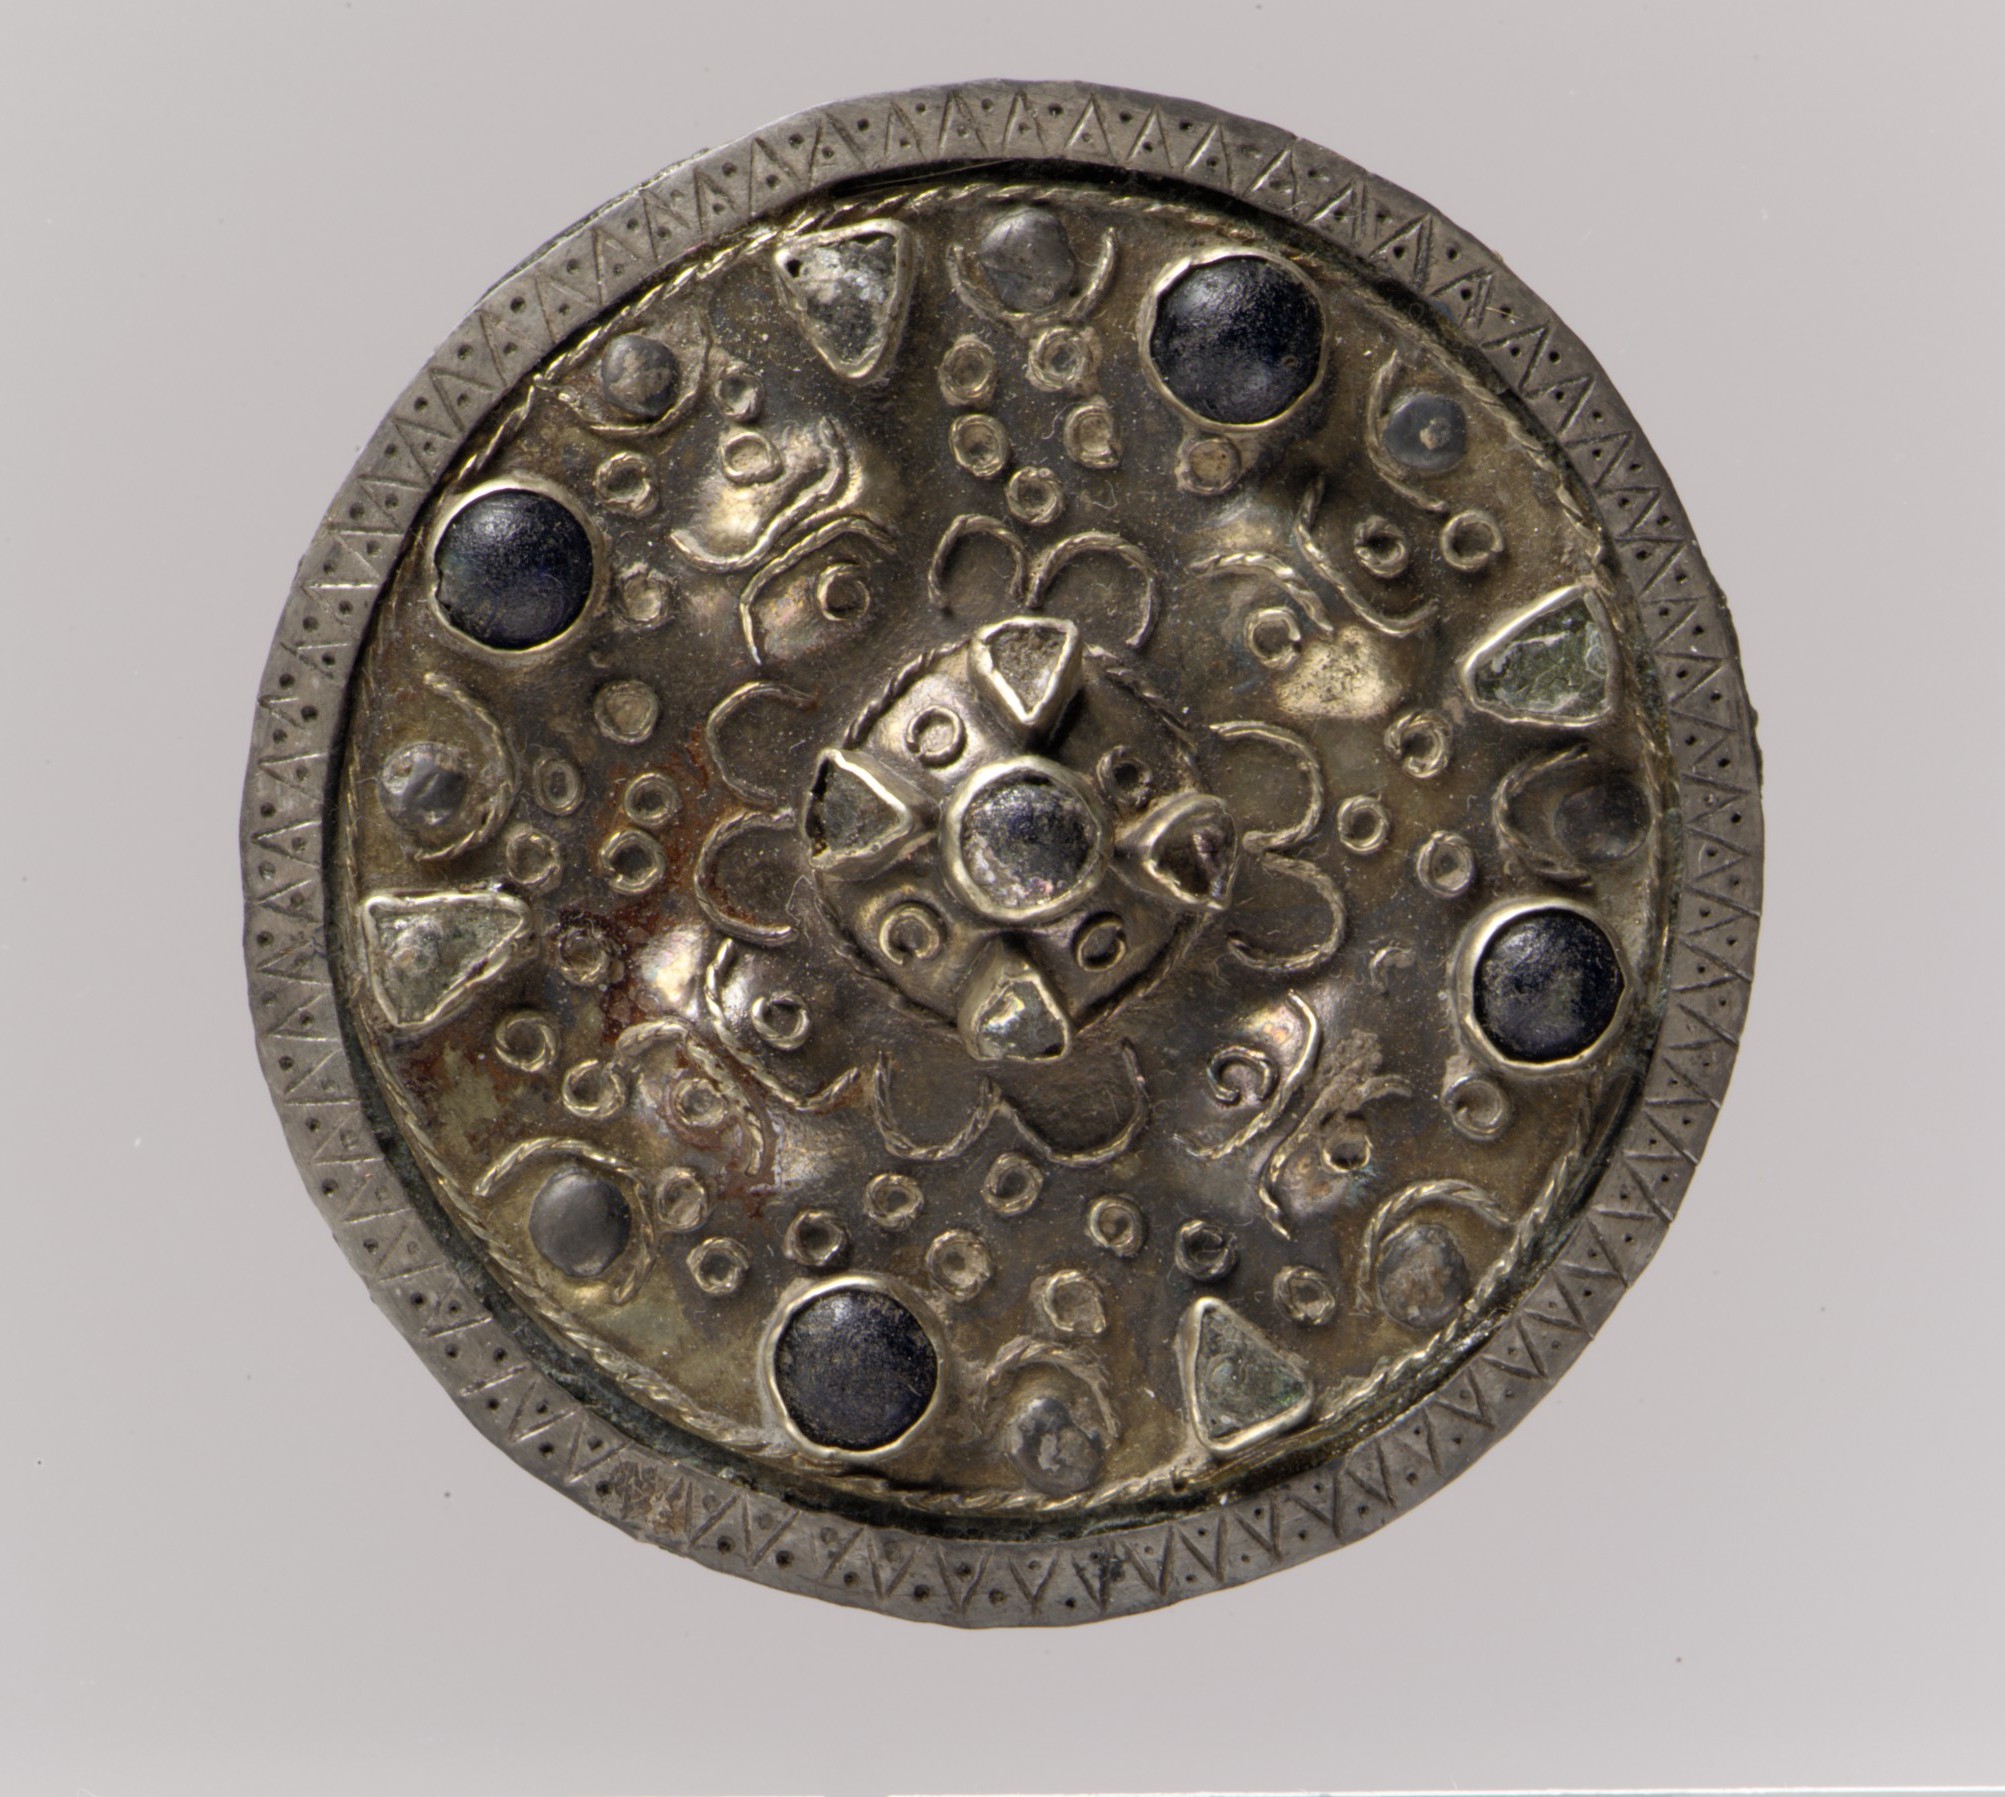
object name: brooch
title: Disk Brooch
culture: frankish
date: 601-700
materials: copper alloy, gold, iron, paste, silver, metal